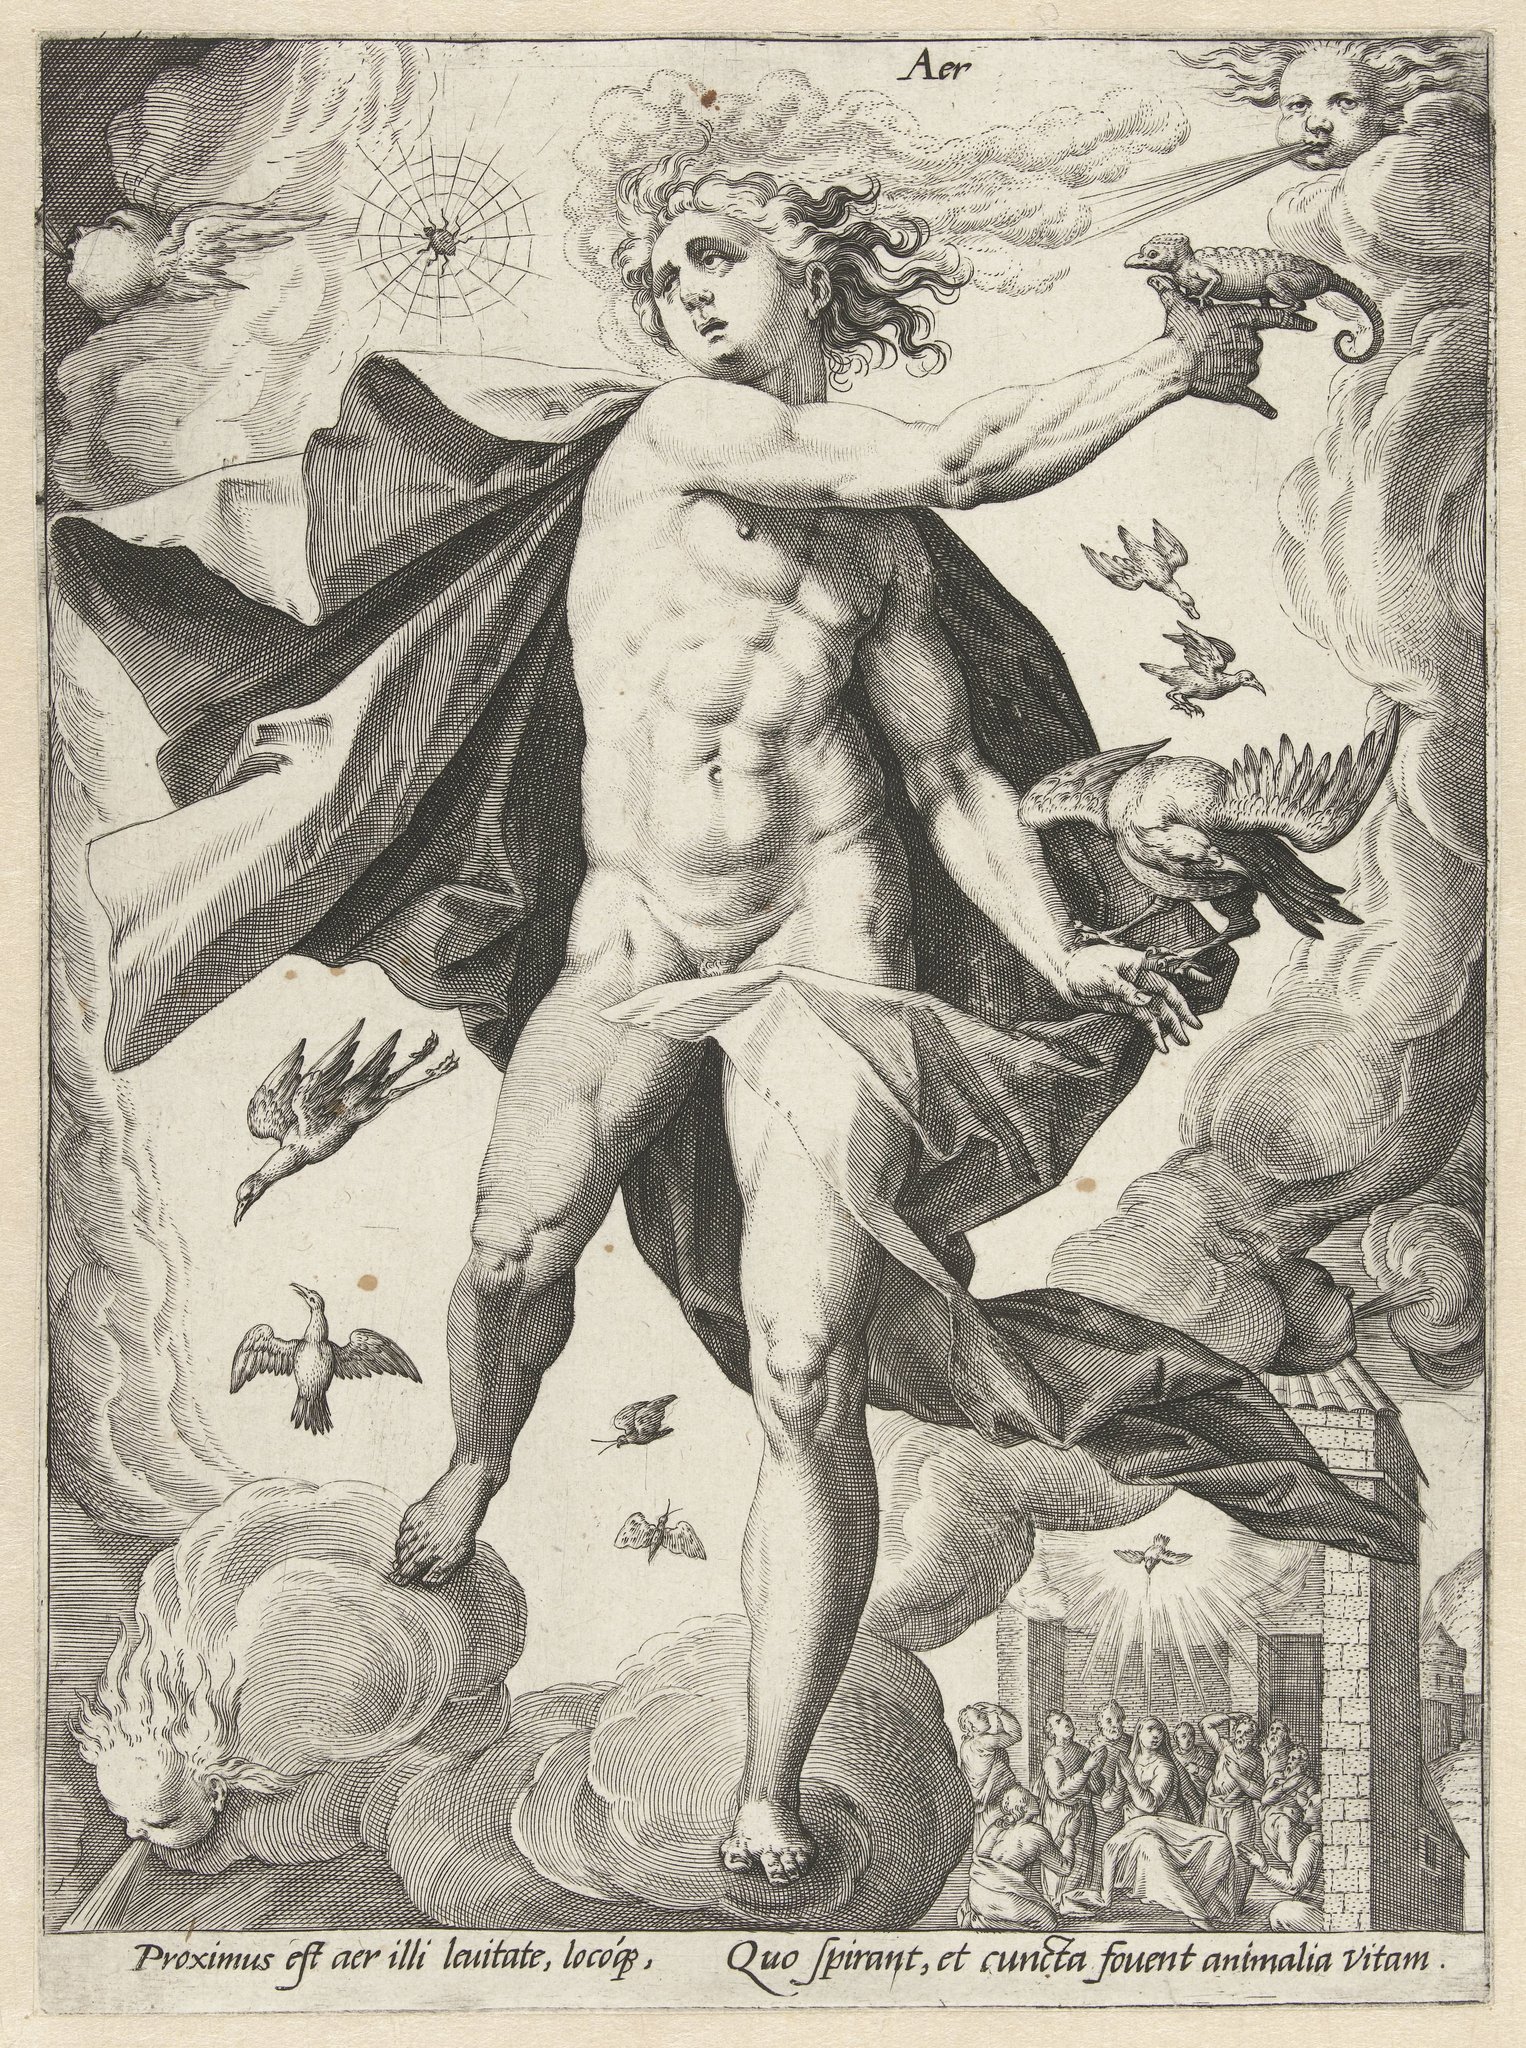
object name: print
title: De vier elementen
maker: hendrick goltzius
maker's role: draughtsman, painter, print maker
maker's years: 1558-1617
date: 1586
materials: paper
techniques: engraving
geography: haarlem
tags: air (one of the four elements)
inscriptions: collector's mark: Lugt 240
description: Man, staande op wolken, een kameleon op de rechterhand, een vogel op de linkerhand. Op de achtergrond de uitstorting van de Heilige Geest over de apostelen. Onder de voorstelling twee regels Latijn. Deze prent is onderdeel van een serie van de vier elementen.